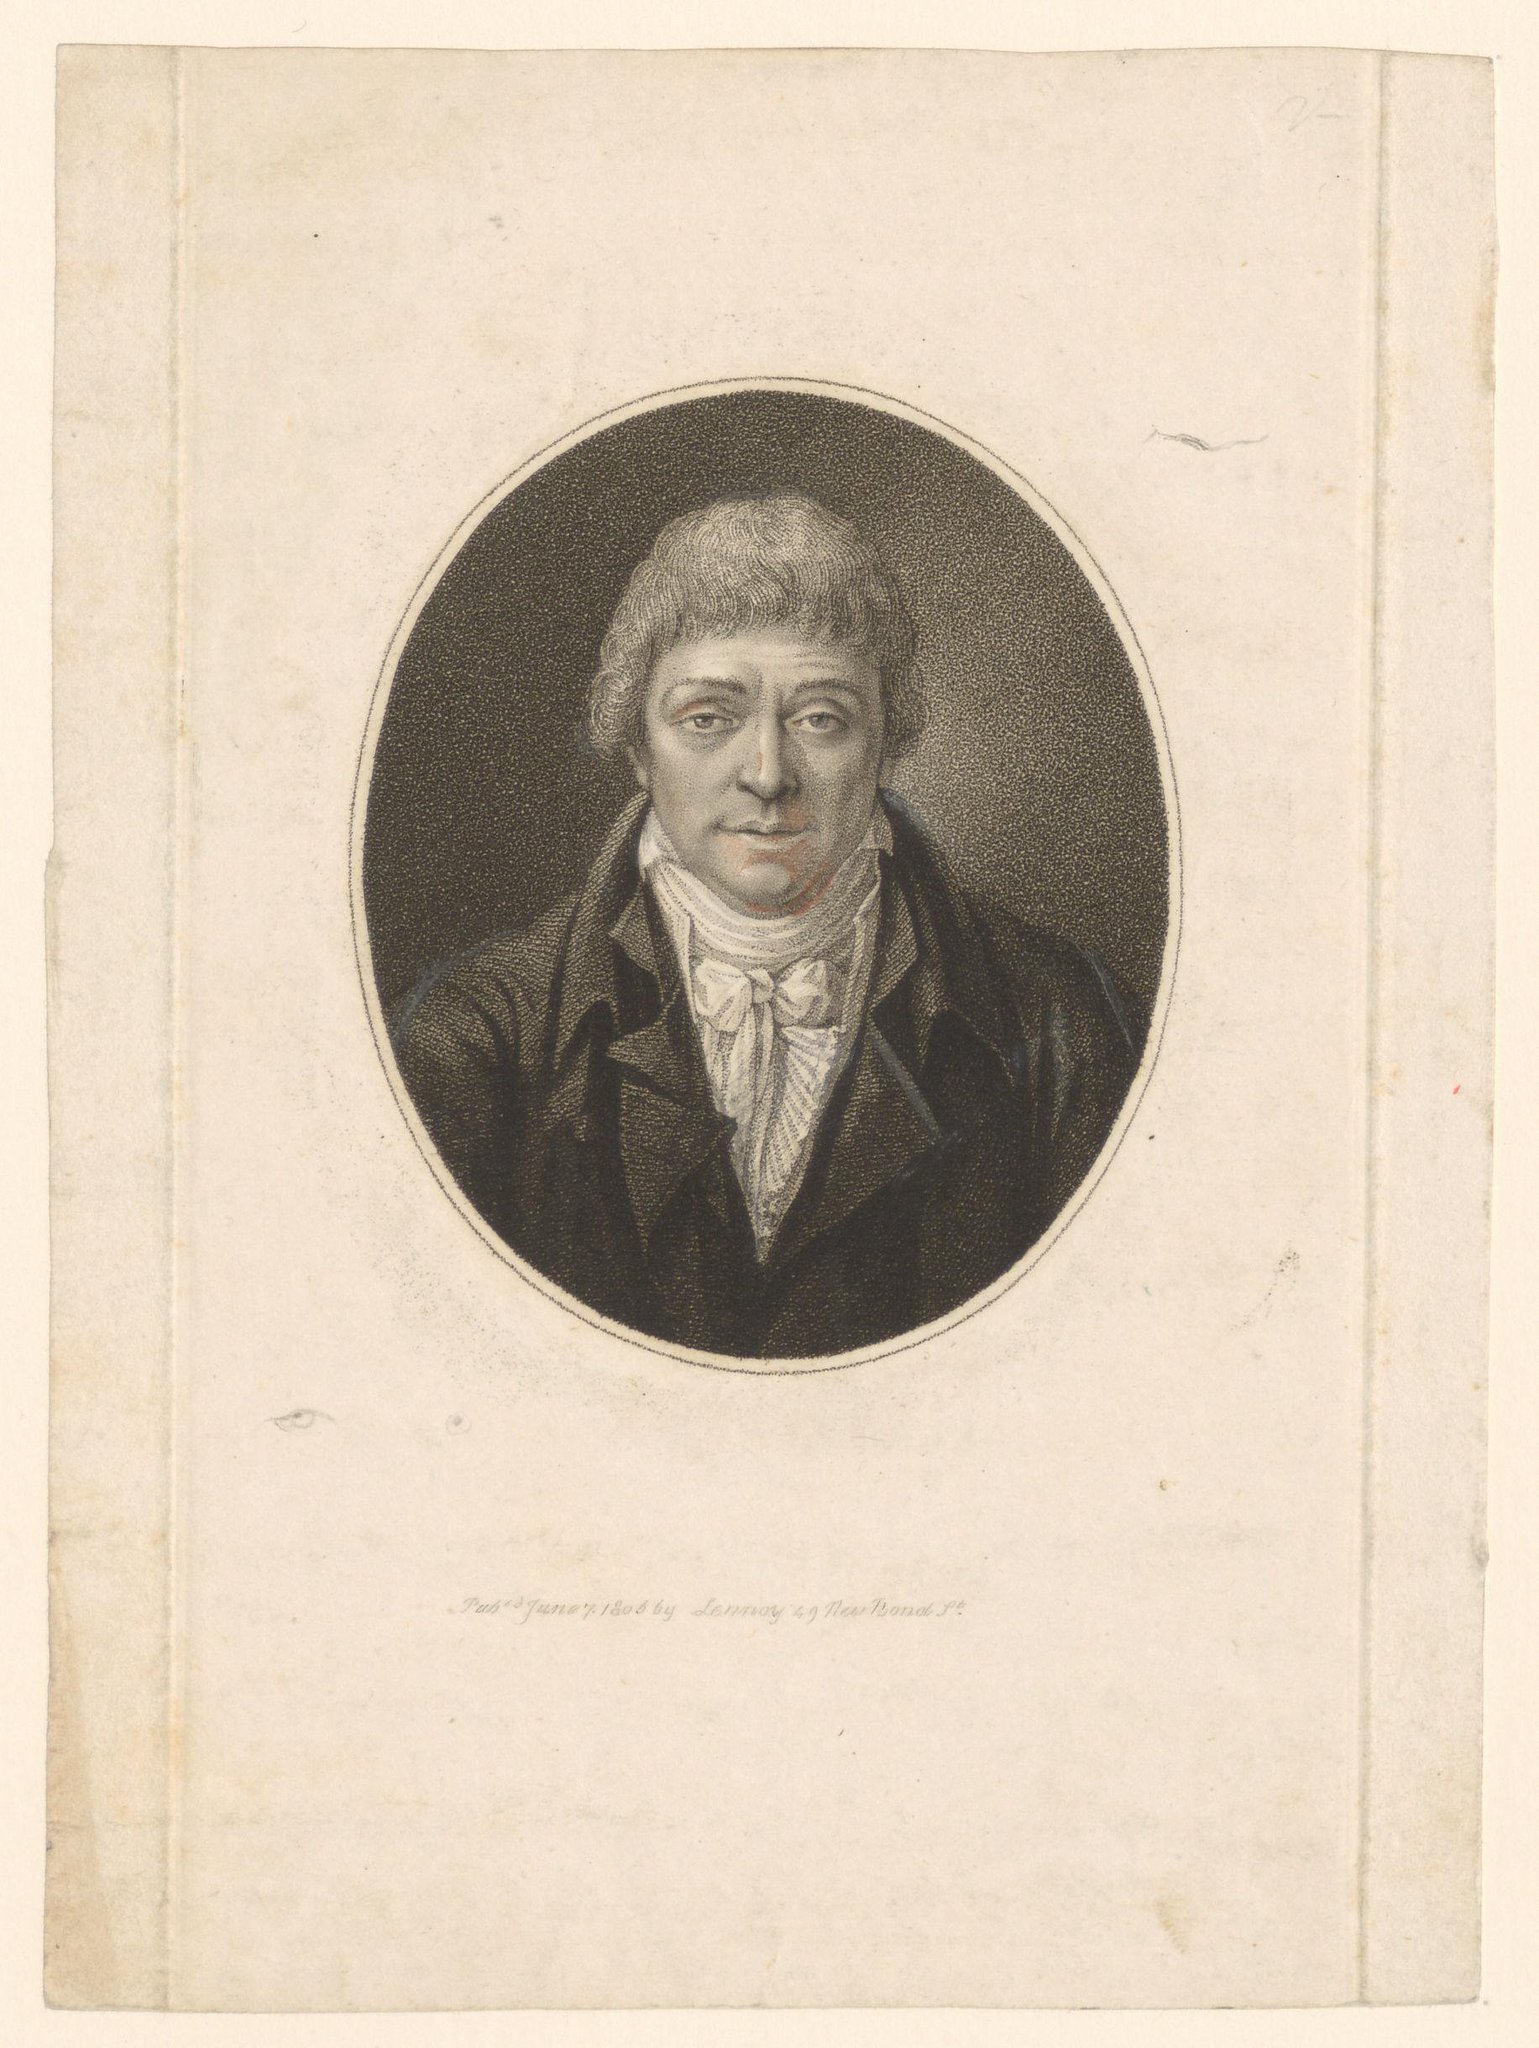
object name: print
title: Portret van P.V. Lenoir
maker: peltro william tomkins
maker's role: print maker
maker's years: 1760-1840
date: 1806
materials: paper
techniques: engraving, hand coloring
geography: london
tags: historical persons, portrait of a writer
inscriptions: collector's mark: Lugt 2228